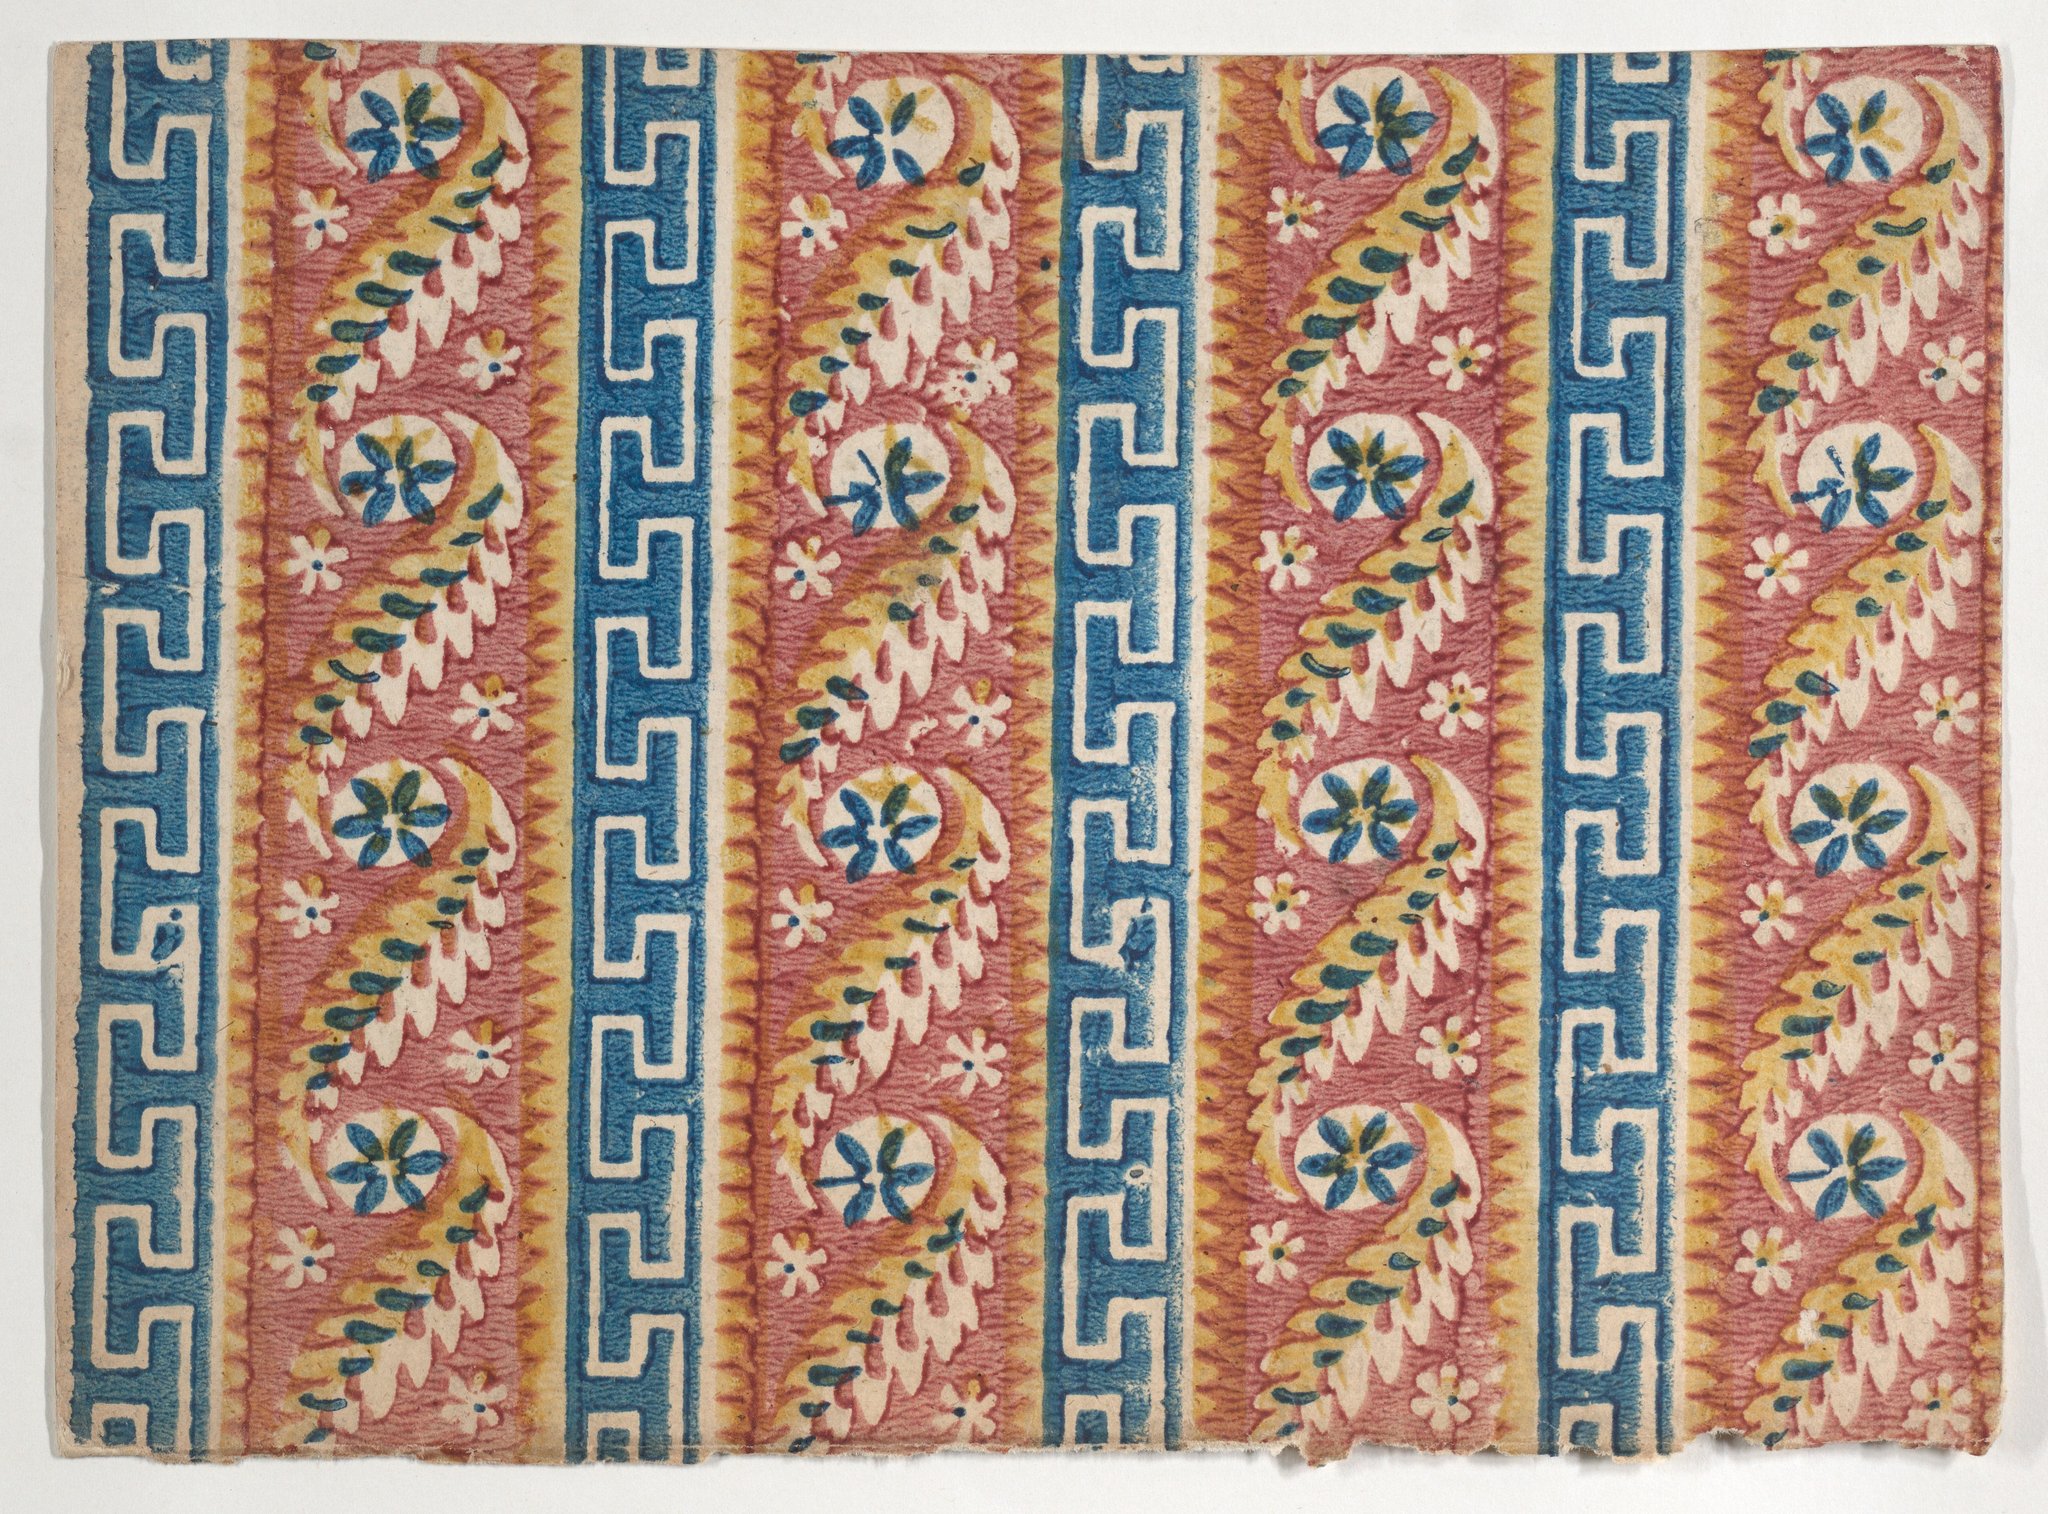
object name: print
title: Sheet with Greek key and paisley pattern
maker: Anonymous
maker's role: artist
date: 1701-1800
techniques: relief print